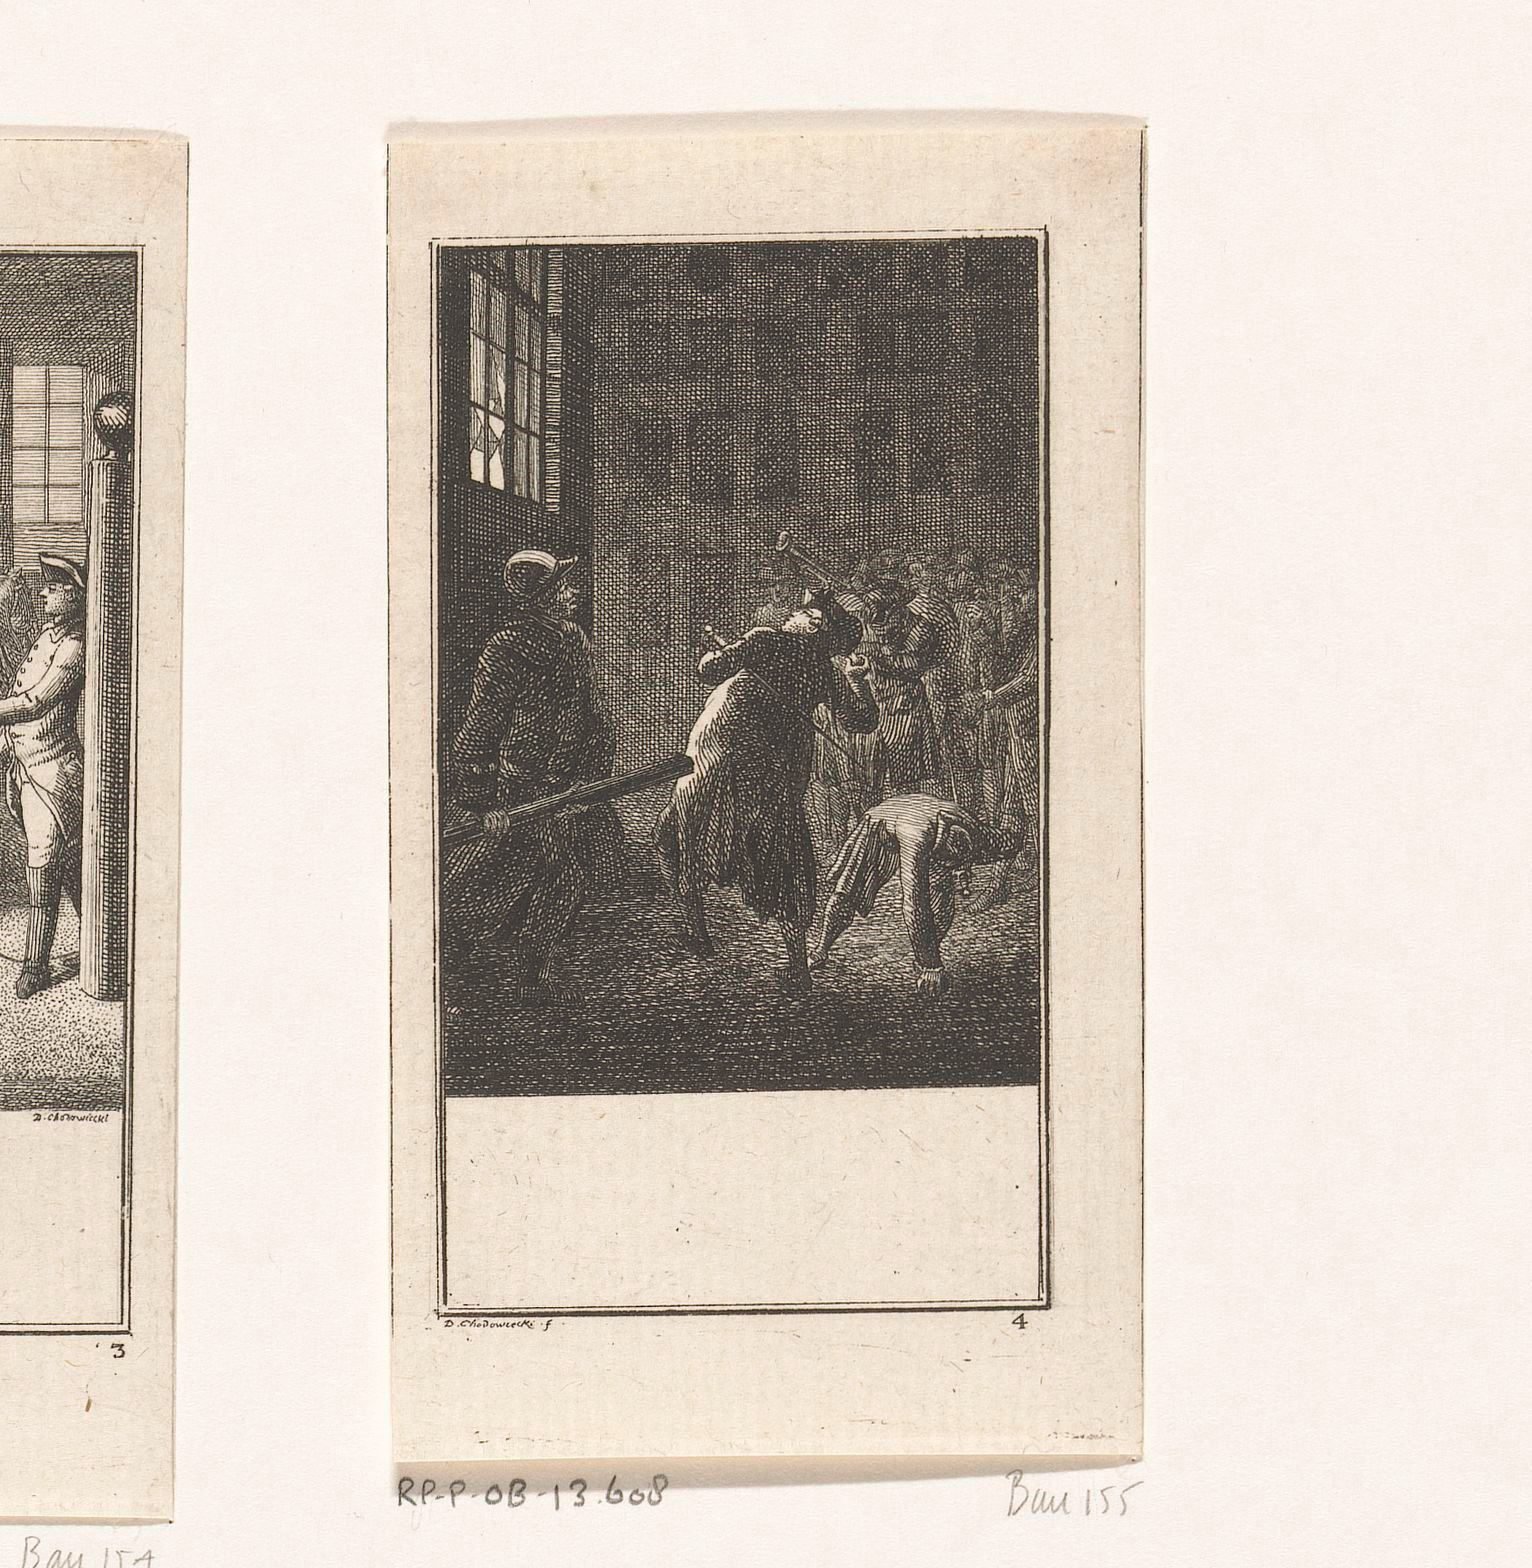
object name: print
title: Universitäts Studien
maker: daniel nikolaus chodowiecki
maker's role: draughtsman, print maker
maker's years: 1726-1801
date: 1773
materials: paper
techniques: etching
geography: berlin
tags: students' riot, night patrol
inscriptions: collector's mark: Lugt 2228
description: Vierde prent uit een serie met 12 scènes uit 'een liederlijk leven'. De twaalf scènes werden samen op een plaat geëtst. De tweede staat van deze serie is gebruikt als illustratie in: 'Berliner genealogischen Calender auf das Jahr 1774'. Aan de hand van deze prentserie schreef Johann Christian Ludwig Haken (1767-1835) zijn briefroman 'Der Lüderliche'.